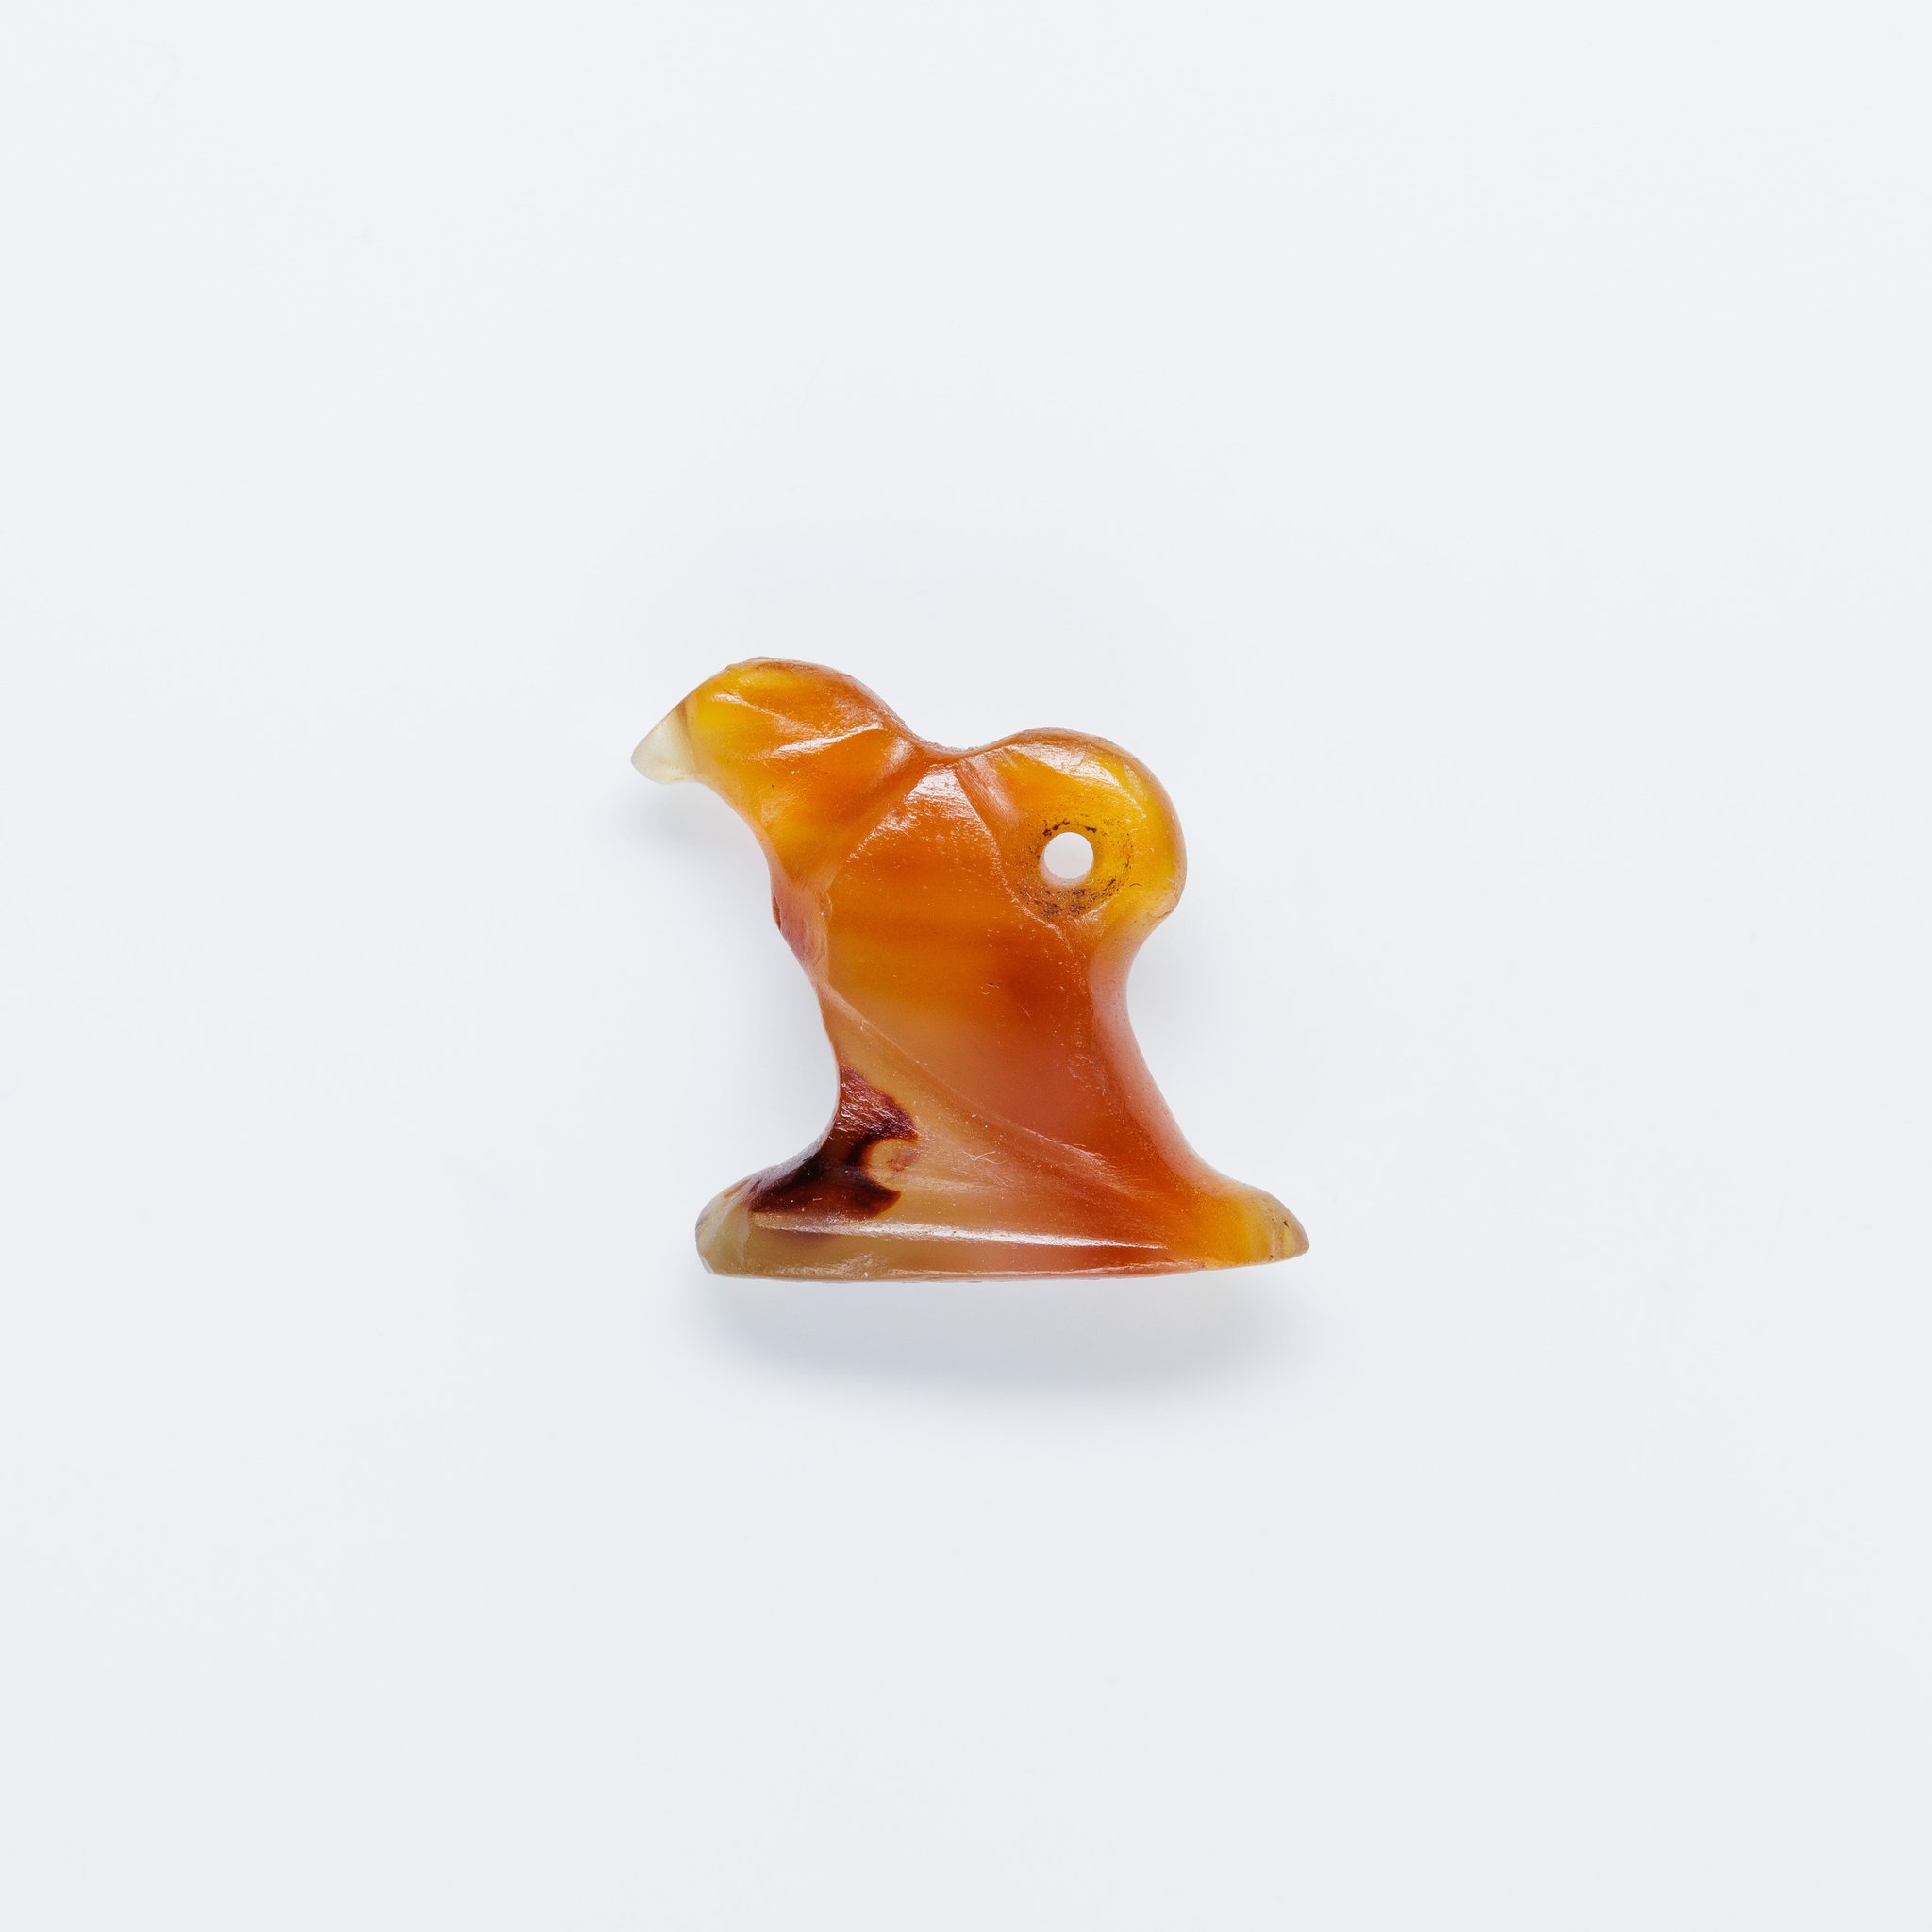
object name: amulet, falcon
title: Falcon Amulet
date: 2150-1950 BCE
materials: gemstone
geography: southern upper egypt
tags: falcons